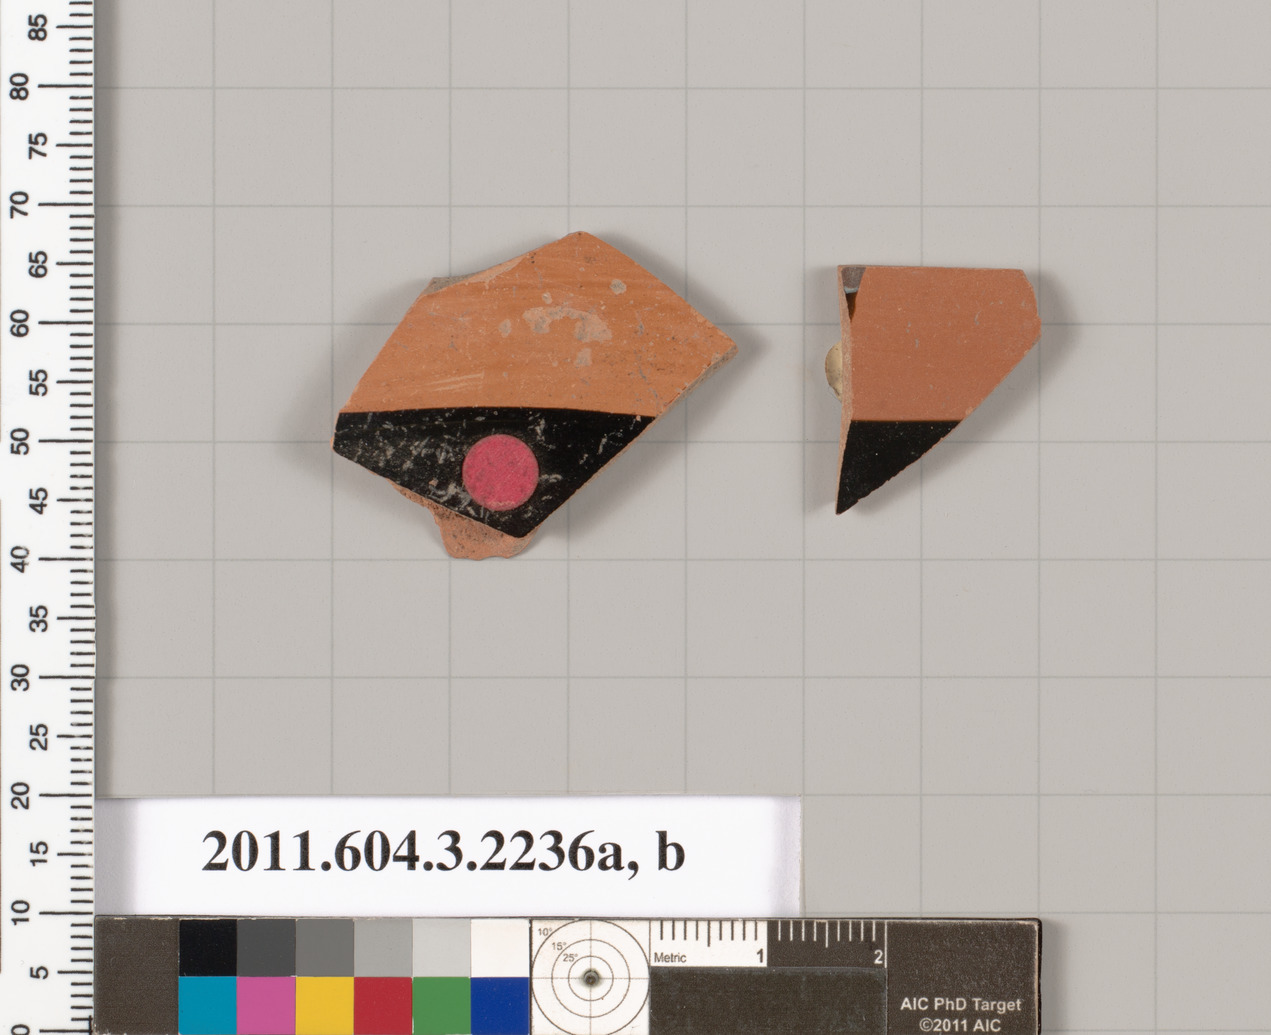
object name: kylix fragment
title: Terracotta fragments of kylikes (drinking cups)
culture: greek, attic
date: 600-401 BCE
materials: terracotta